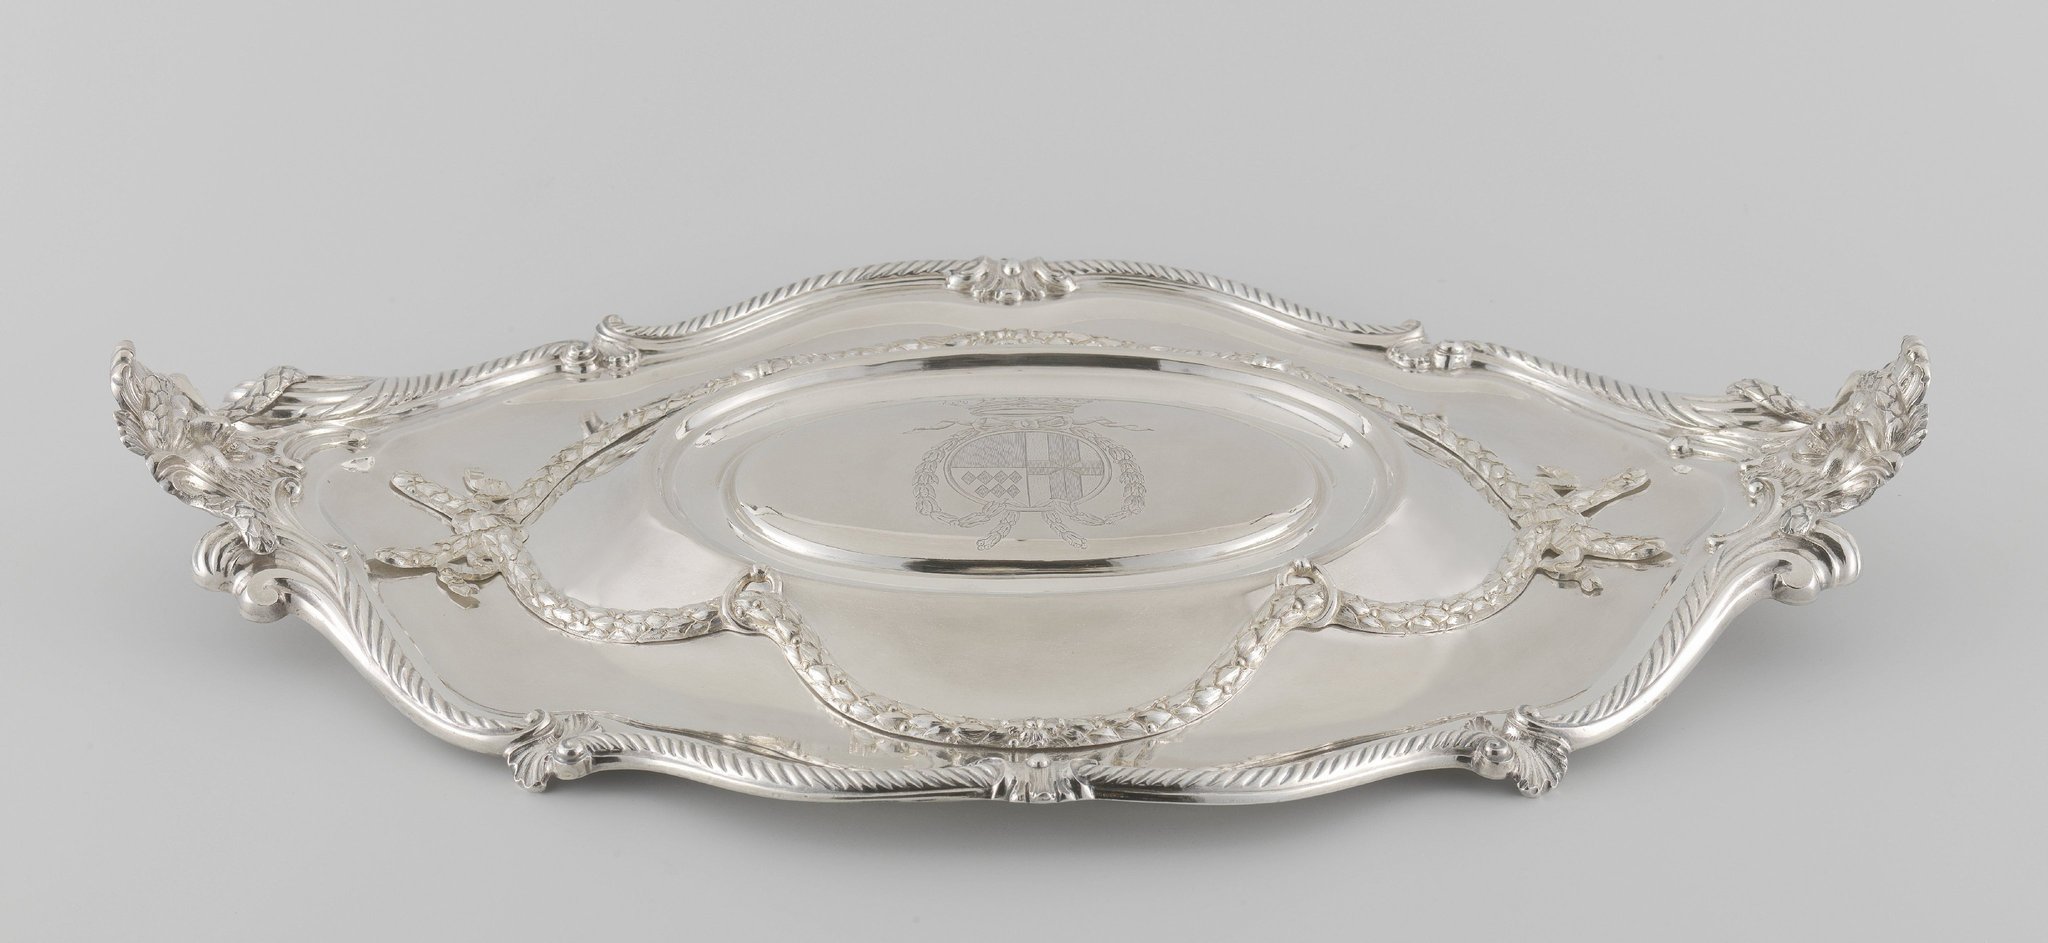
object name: tureen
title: Tureen and stand with a ladle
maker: engelbart joosten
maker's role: silversmith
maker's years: 1717-1789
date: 1772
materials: silver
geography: the hague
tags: armorial bearing, heraldry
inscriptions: inscription: ‘Op terrine, onderschotel en lepel de gecombineerde wapens gegraveerd van: Assueer Jan baron Torck, heer van Rosendael, Duivenvoorde, Petkum, Harselo, Voorschoten, Veur en Eusebia Jacoba de Rode van Heeckeren.’, signature and date: ‘Merken: Den Haag; kl. leeuw (tweede gehalte); jrl. A (1772); mt. E. Joosten.’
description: This tureen and stand bear the alliance coat of arms of Baron Assueer Jan Torck and Eusebia Jacoba de Rode van Heeckeren, who were married in 1758. This couple was closely acquainted with the stadtholder and his consort. The imposing tureen, an early example of Neoclassical Hague silver, affords a good impression of the art at and around the stadtholder’s court.